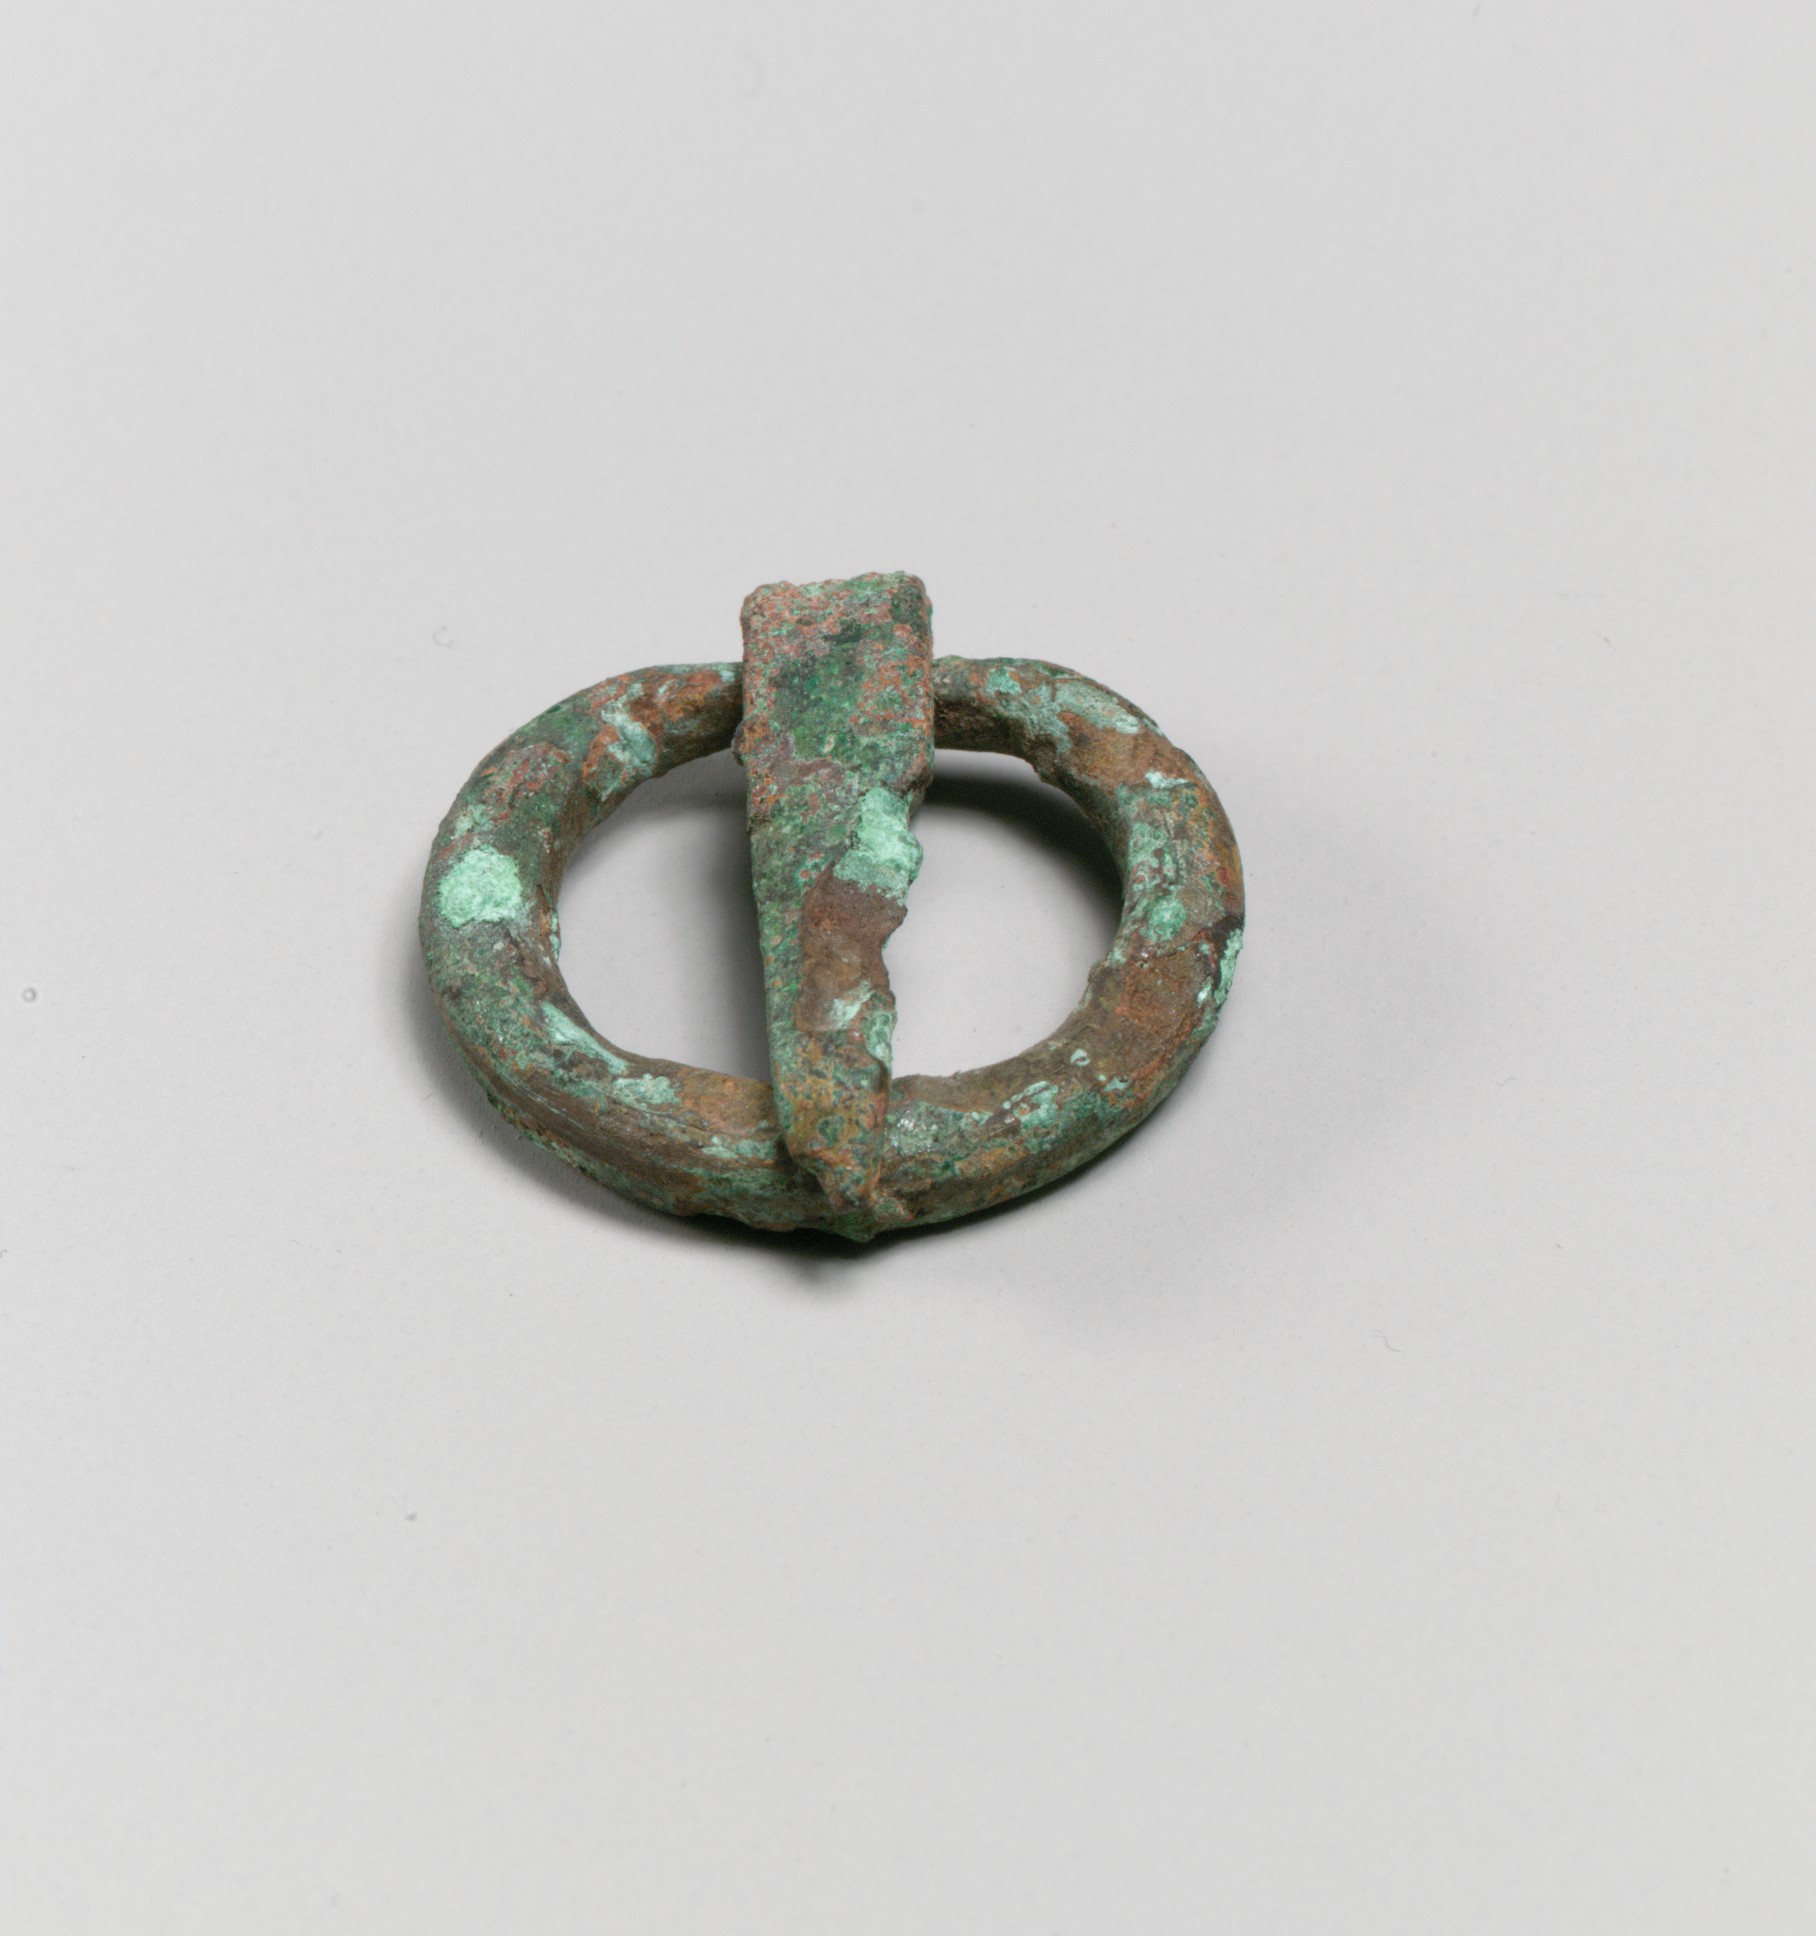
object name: buckle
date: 7000 BCE-330 CE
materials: bronze